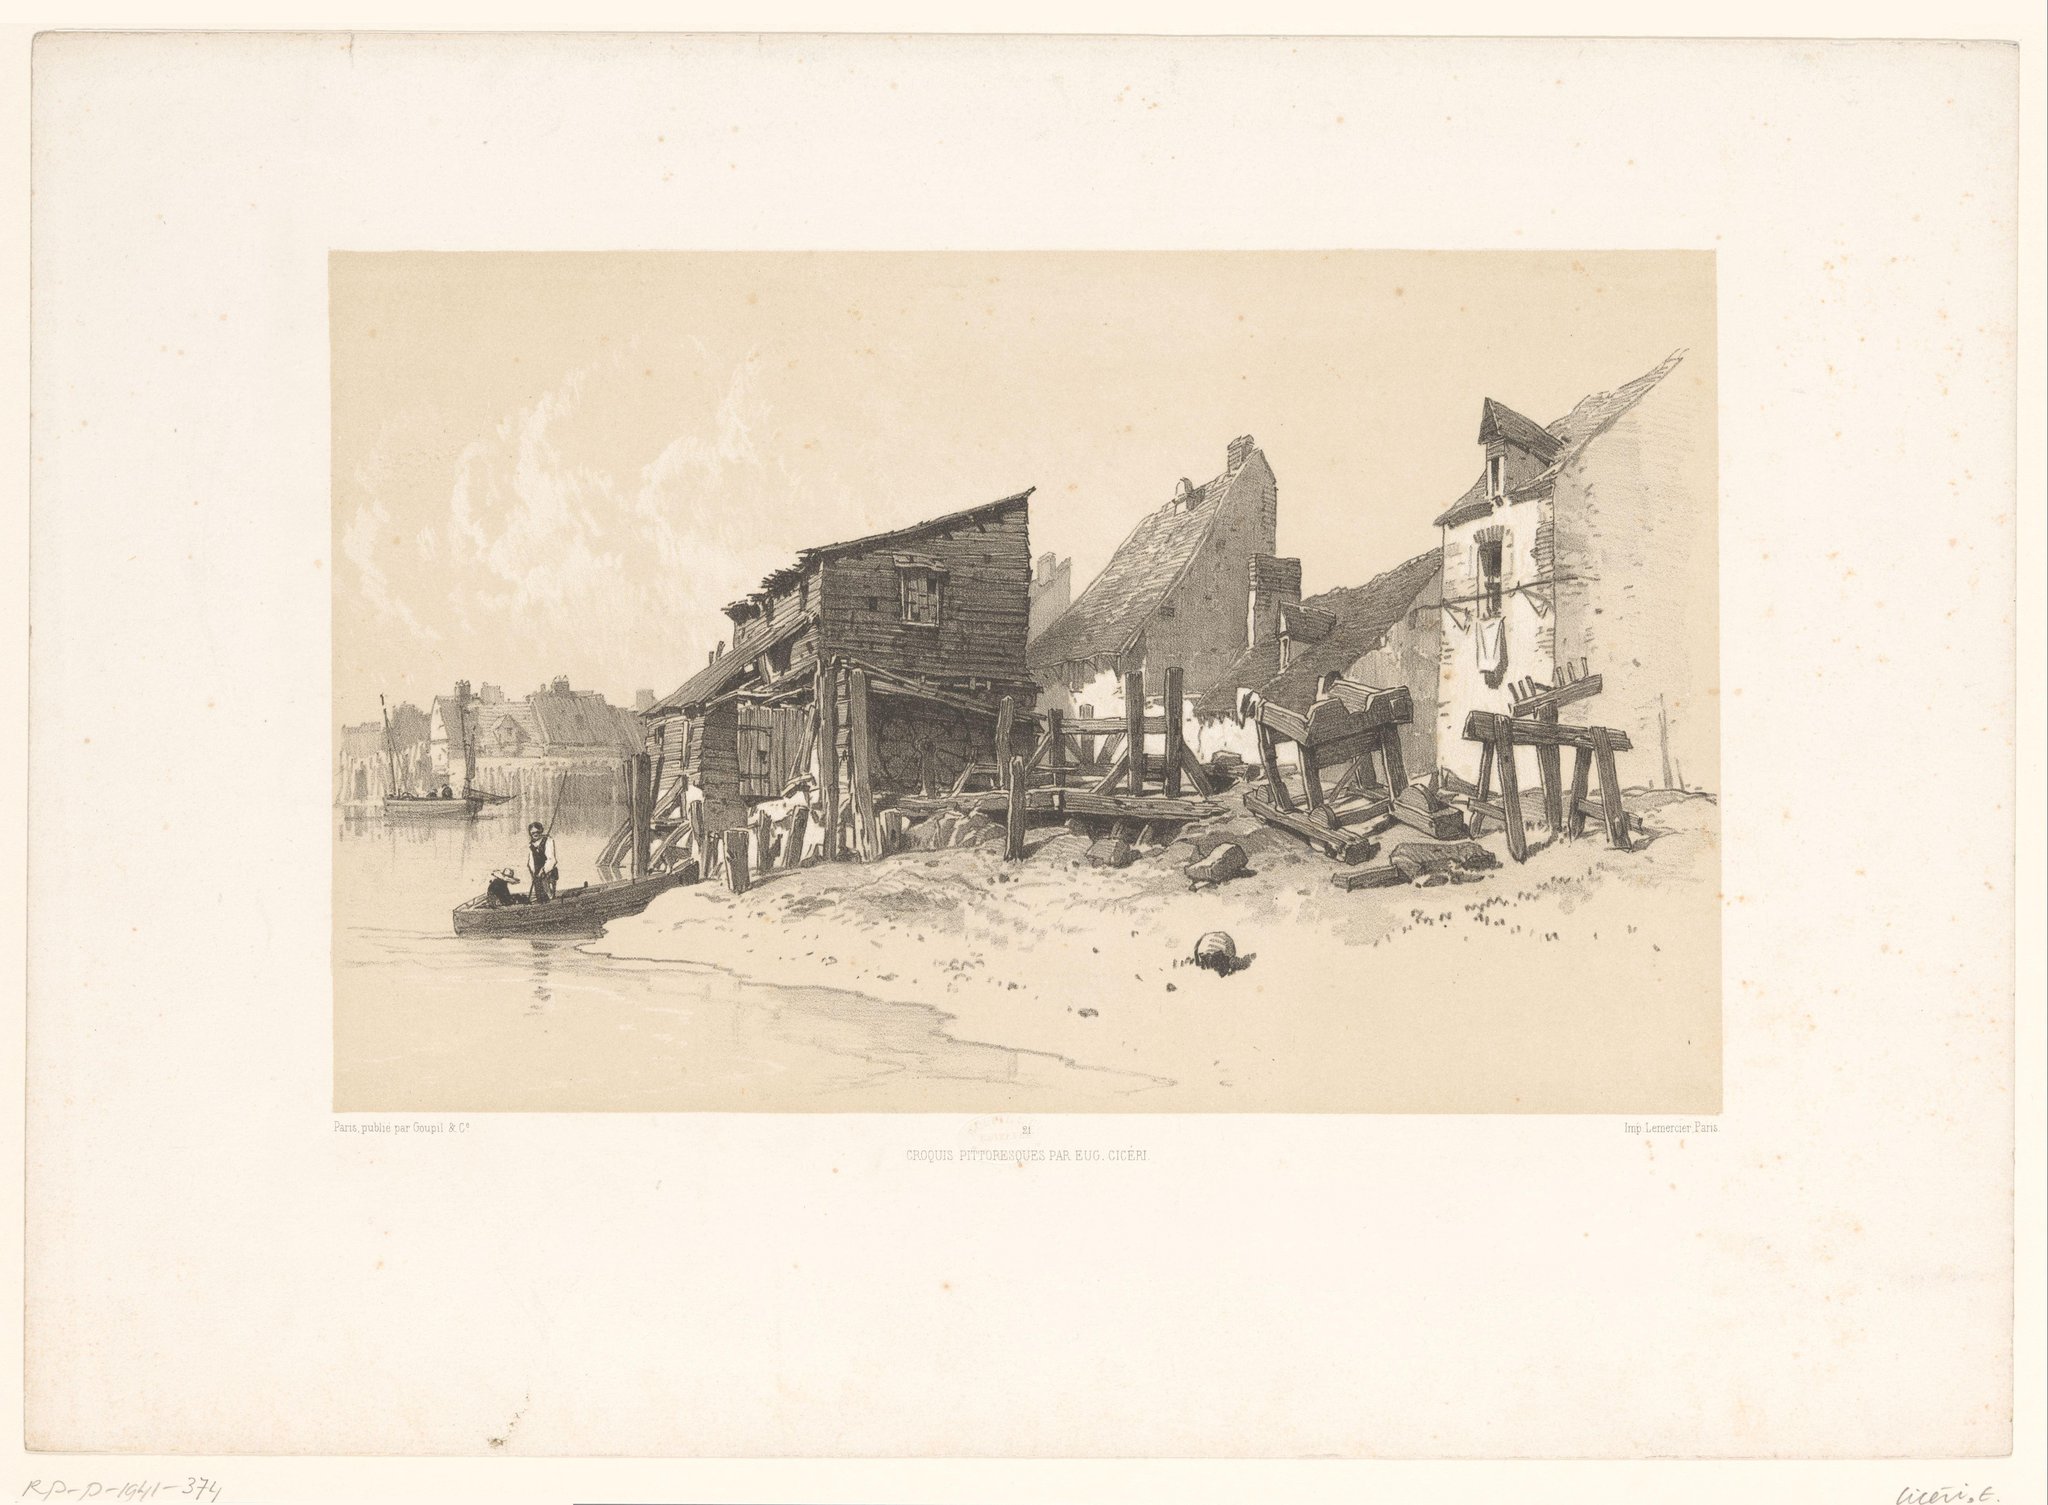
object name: print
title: Croquis pittoresques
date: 1854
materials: paper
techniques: tone lithography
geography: paris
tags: watermill, river (+ landscape with figures, staffage), civic architecture; edifices; dwellings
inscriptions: collector's mark: Lugt 2760, collector's mark: Lugt 2228a, check stamp: Lugt 1090